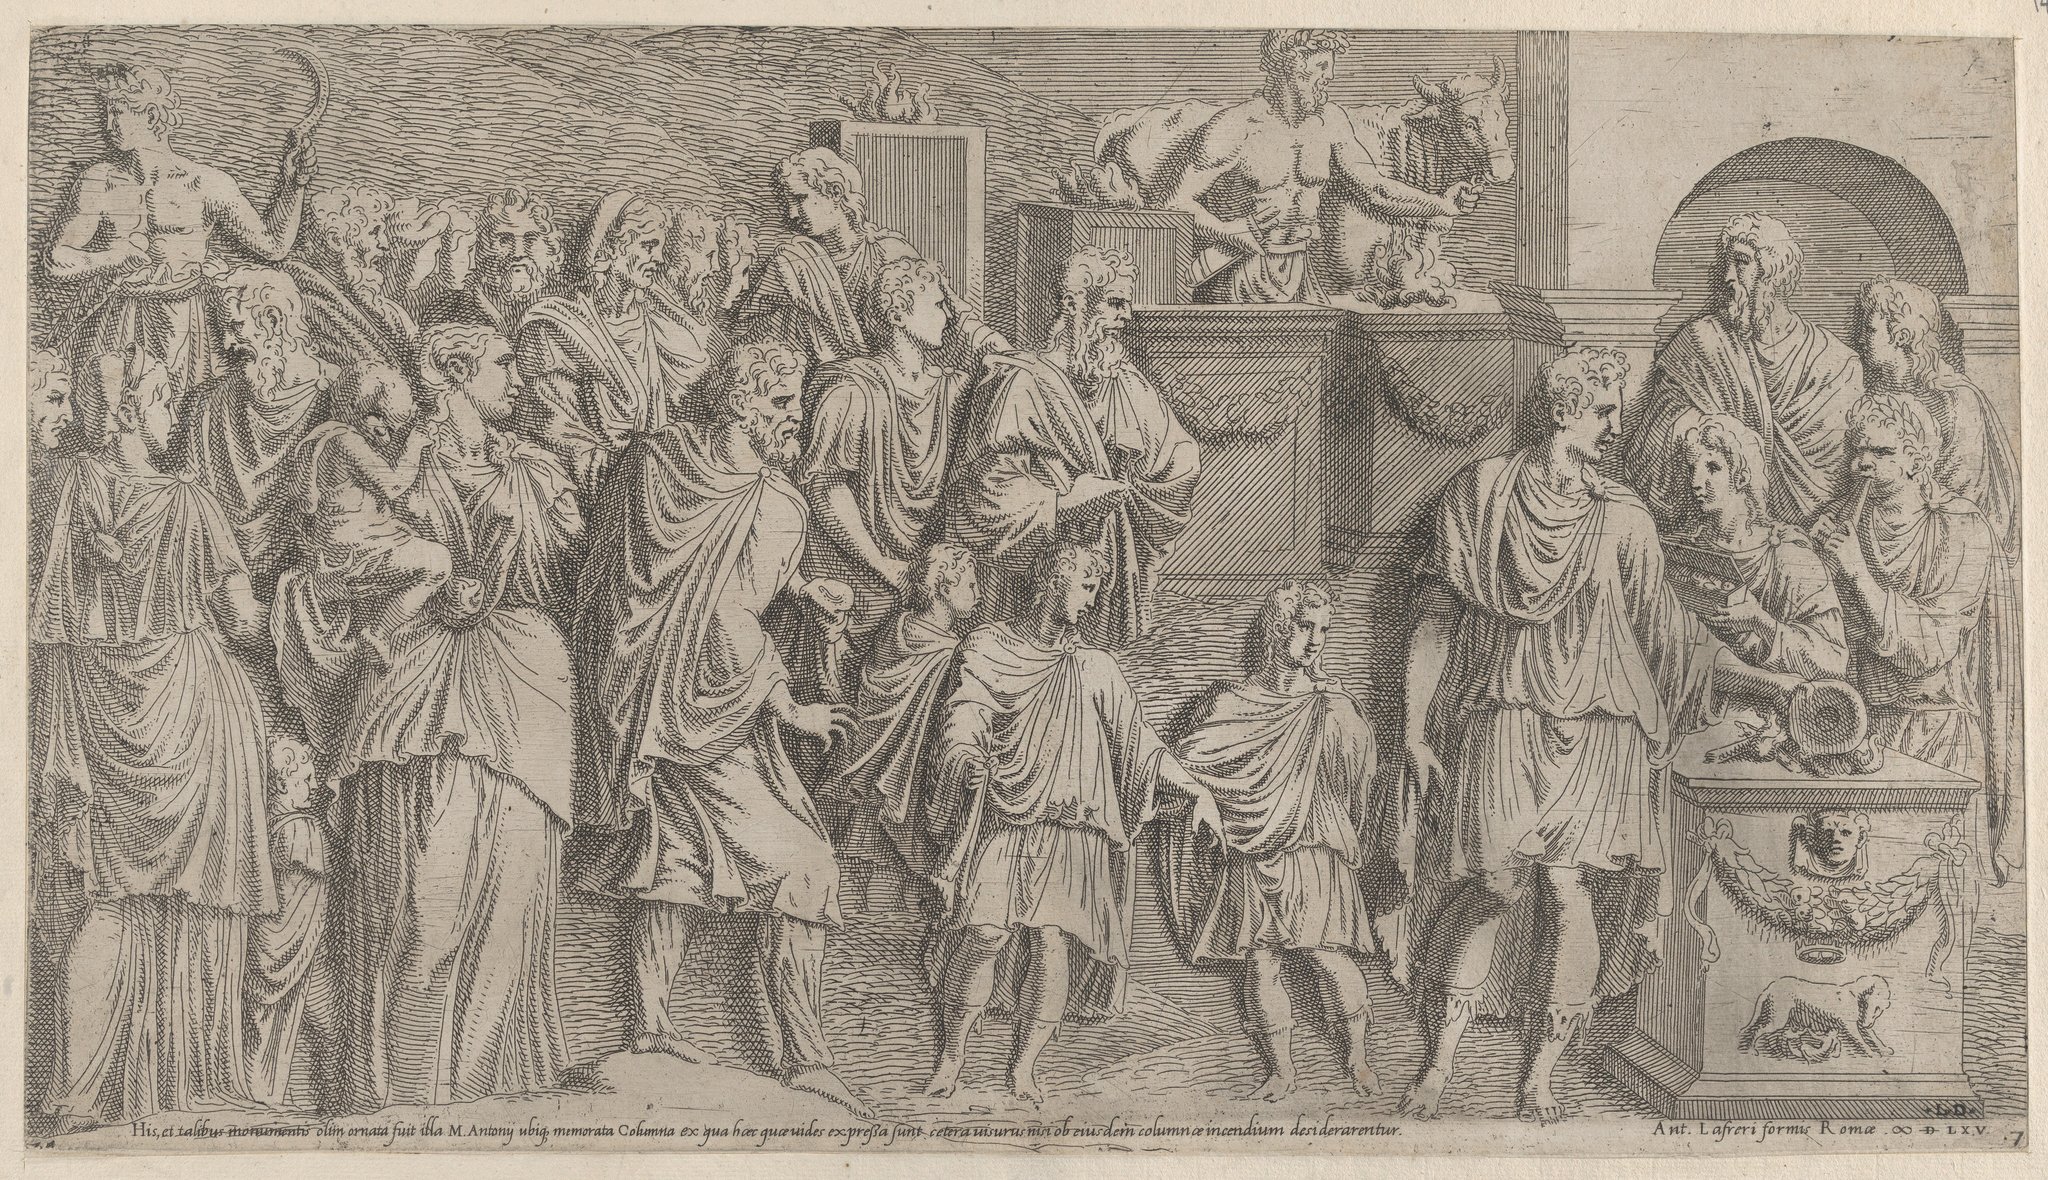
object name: print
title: A Sacrifice, copied from a relief on Trajan's Column, from "Speculum Romanae Magnificentiae"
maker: léon davent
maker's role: artist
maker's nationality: french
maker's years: 1540-1556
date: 1565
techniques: etching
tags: animals,weapons,men,women